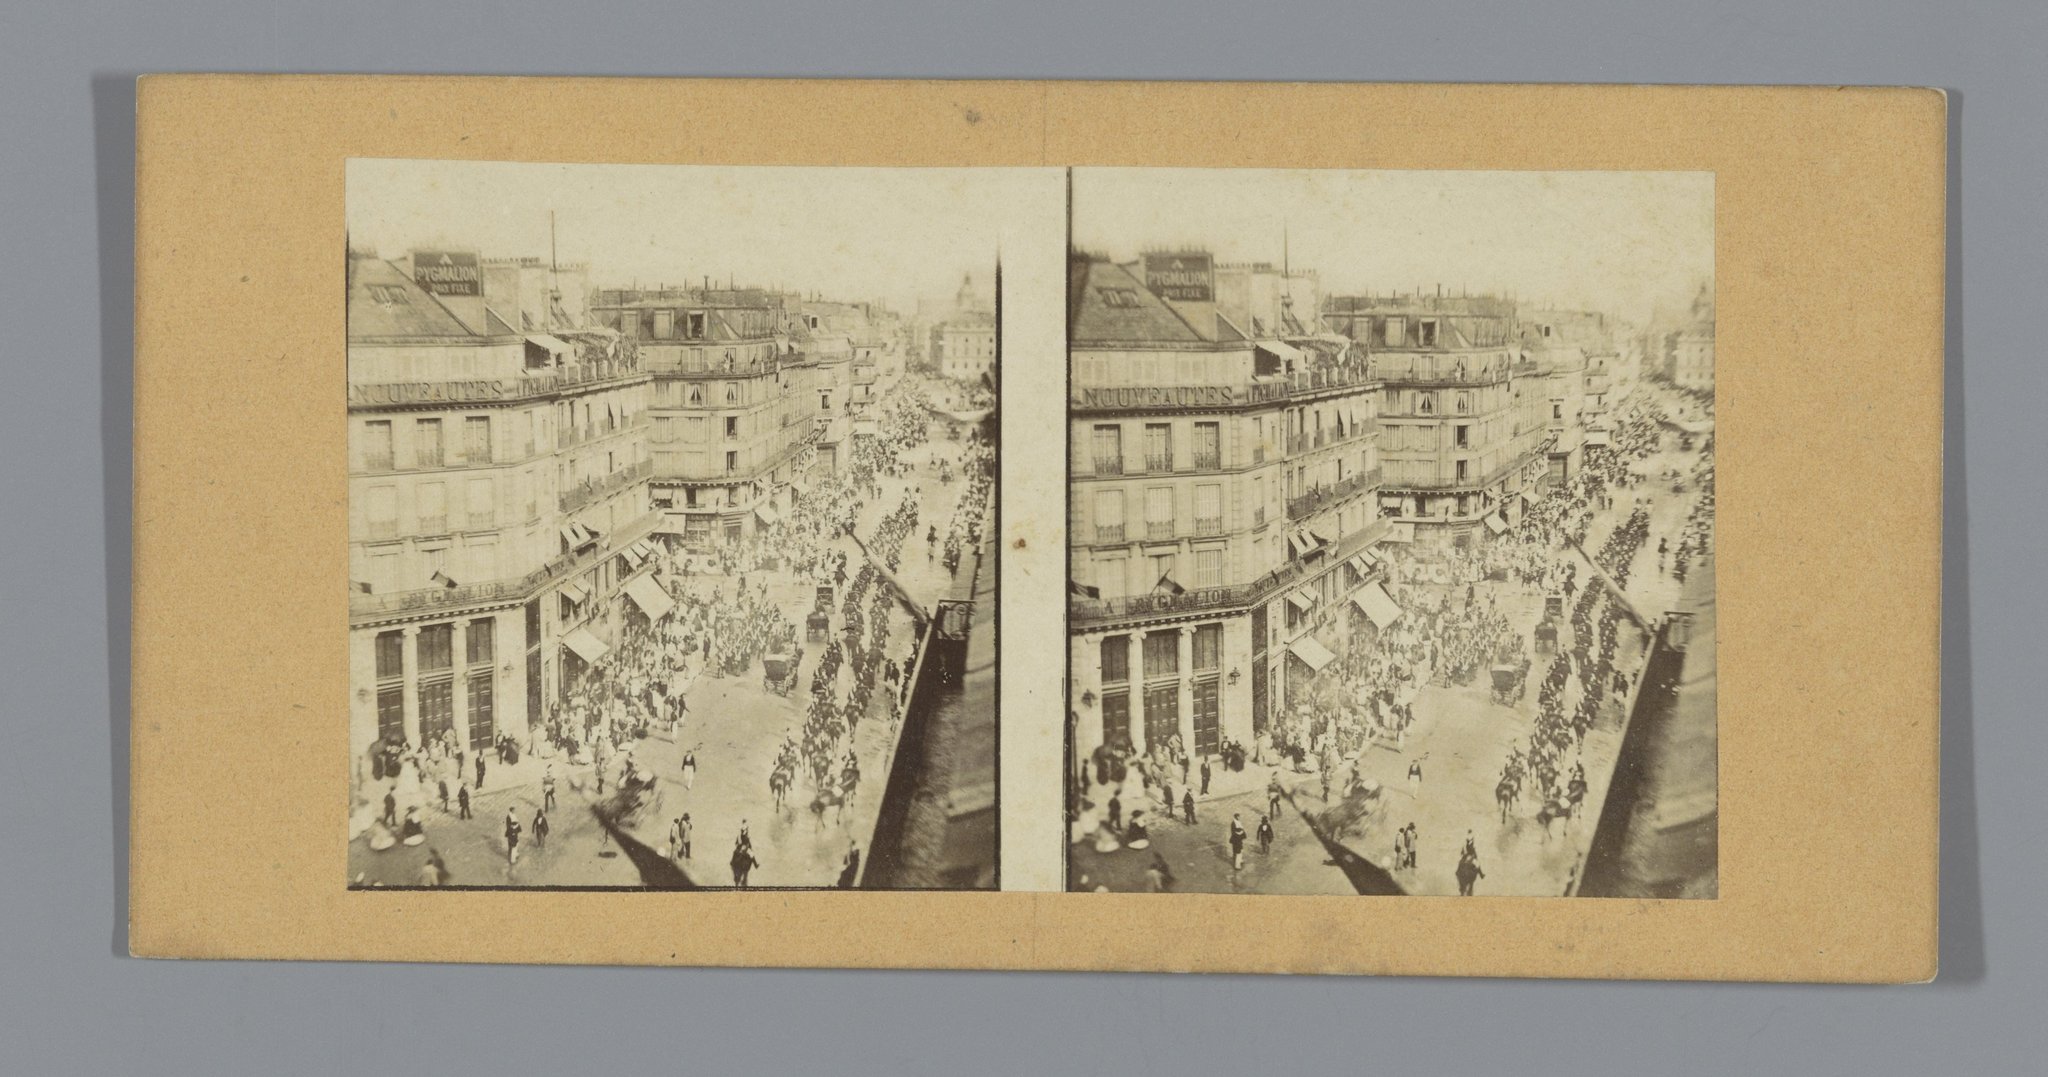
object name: stereograph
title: Gezicht op de intocht van de troepen van keizer Napoleon III in de Rue de Rivoli te Parijs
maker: Anonymous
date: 1859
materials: cardboard, photographic support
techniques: albumen print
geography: rue de rivoli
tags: conqueror triumphing, triumphal entry of victor, the soldier; the soldier's life, street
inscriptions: inscription: ‘Defile de troupes. Rue de Rivoli (Paris)’, date: ‘Parijs 1862-1864-1867-1881-1883-1887-1889.’